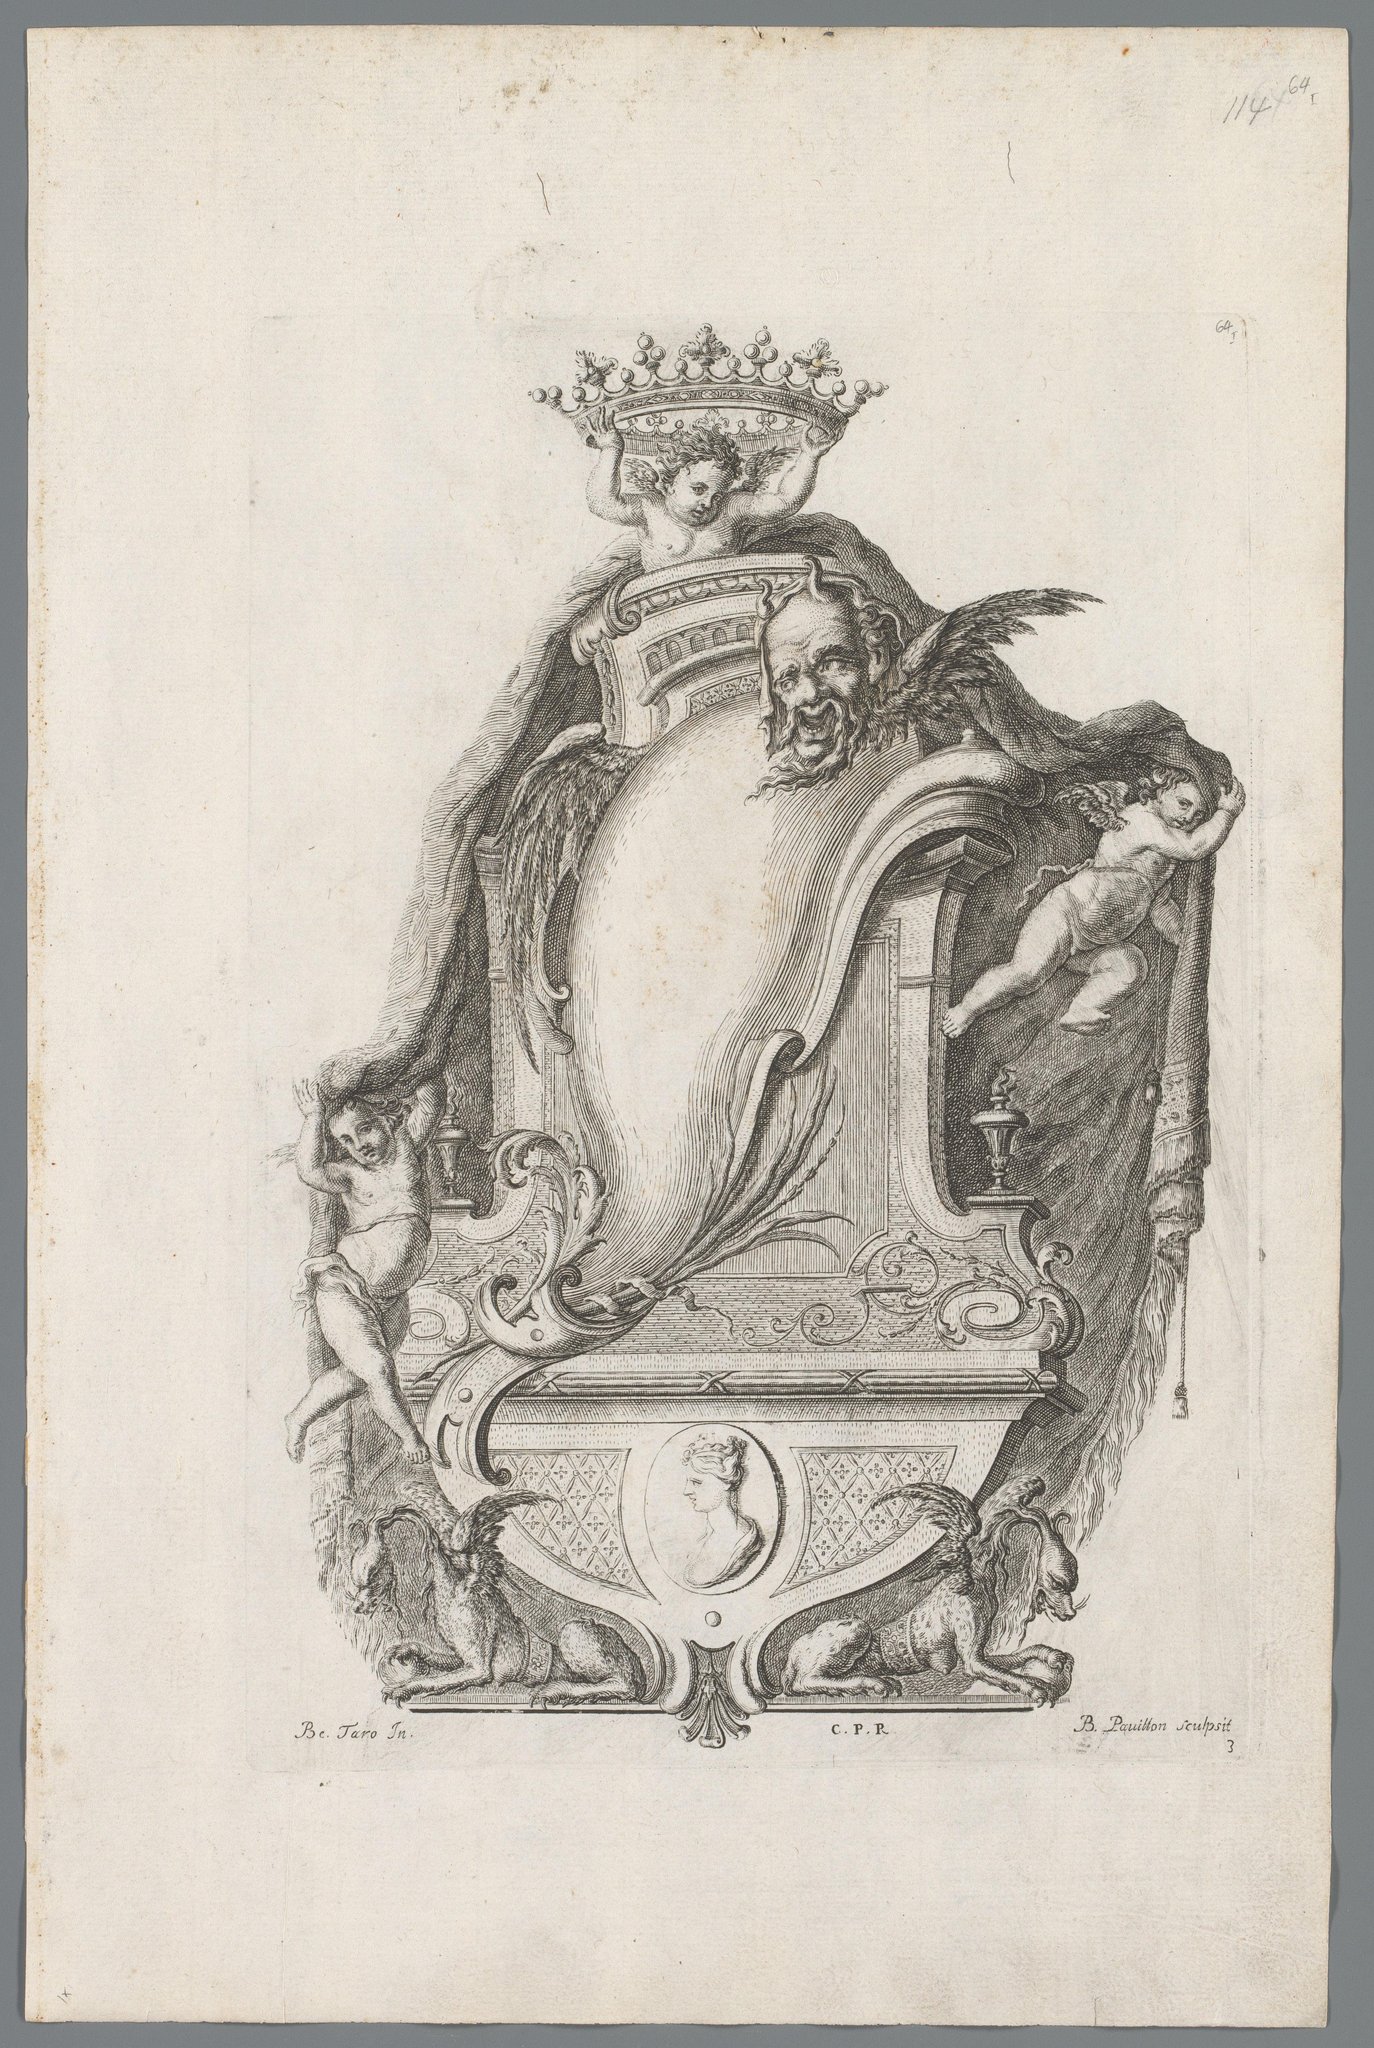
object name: print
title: Livre de cartouches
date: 1682-1729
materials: paper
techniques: etching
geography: aix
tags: devil(s) and demons, ornament ~ cartouche, cupids: 'amores', 'amoretti', 'putti'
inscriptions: collector's mark: Lugt 2228, collector's mark: Lugt 2760